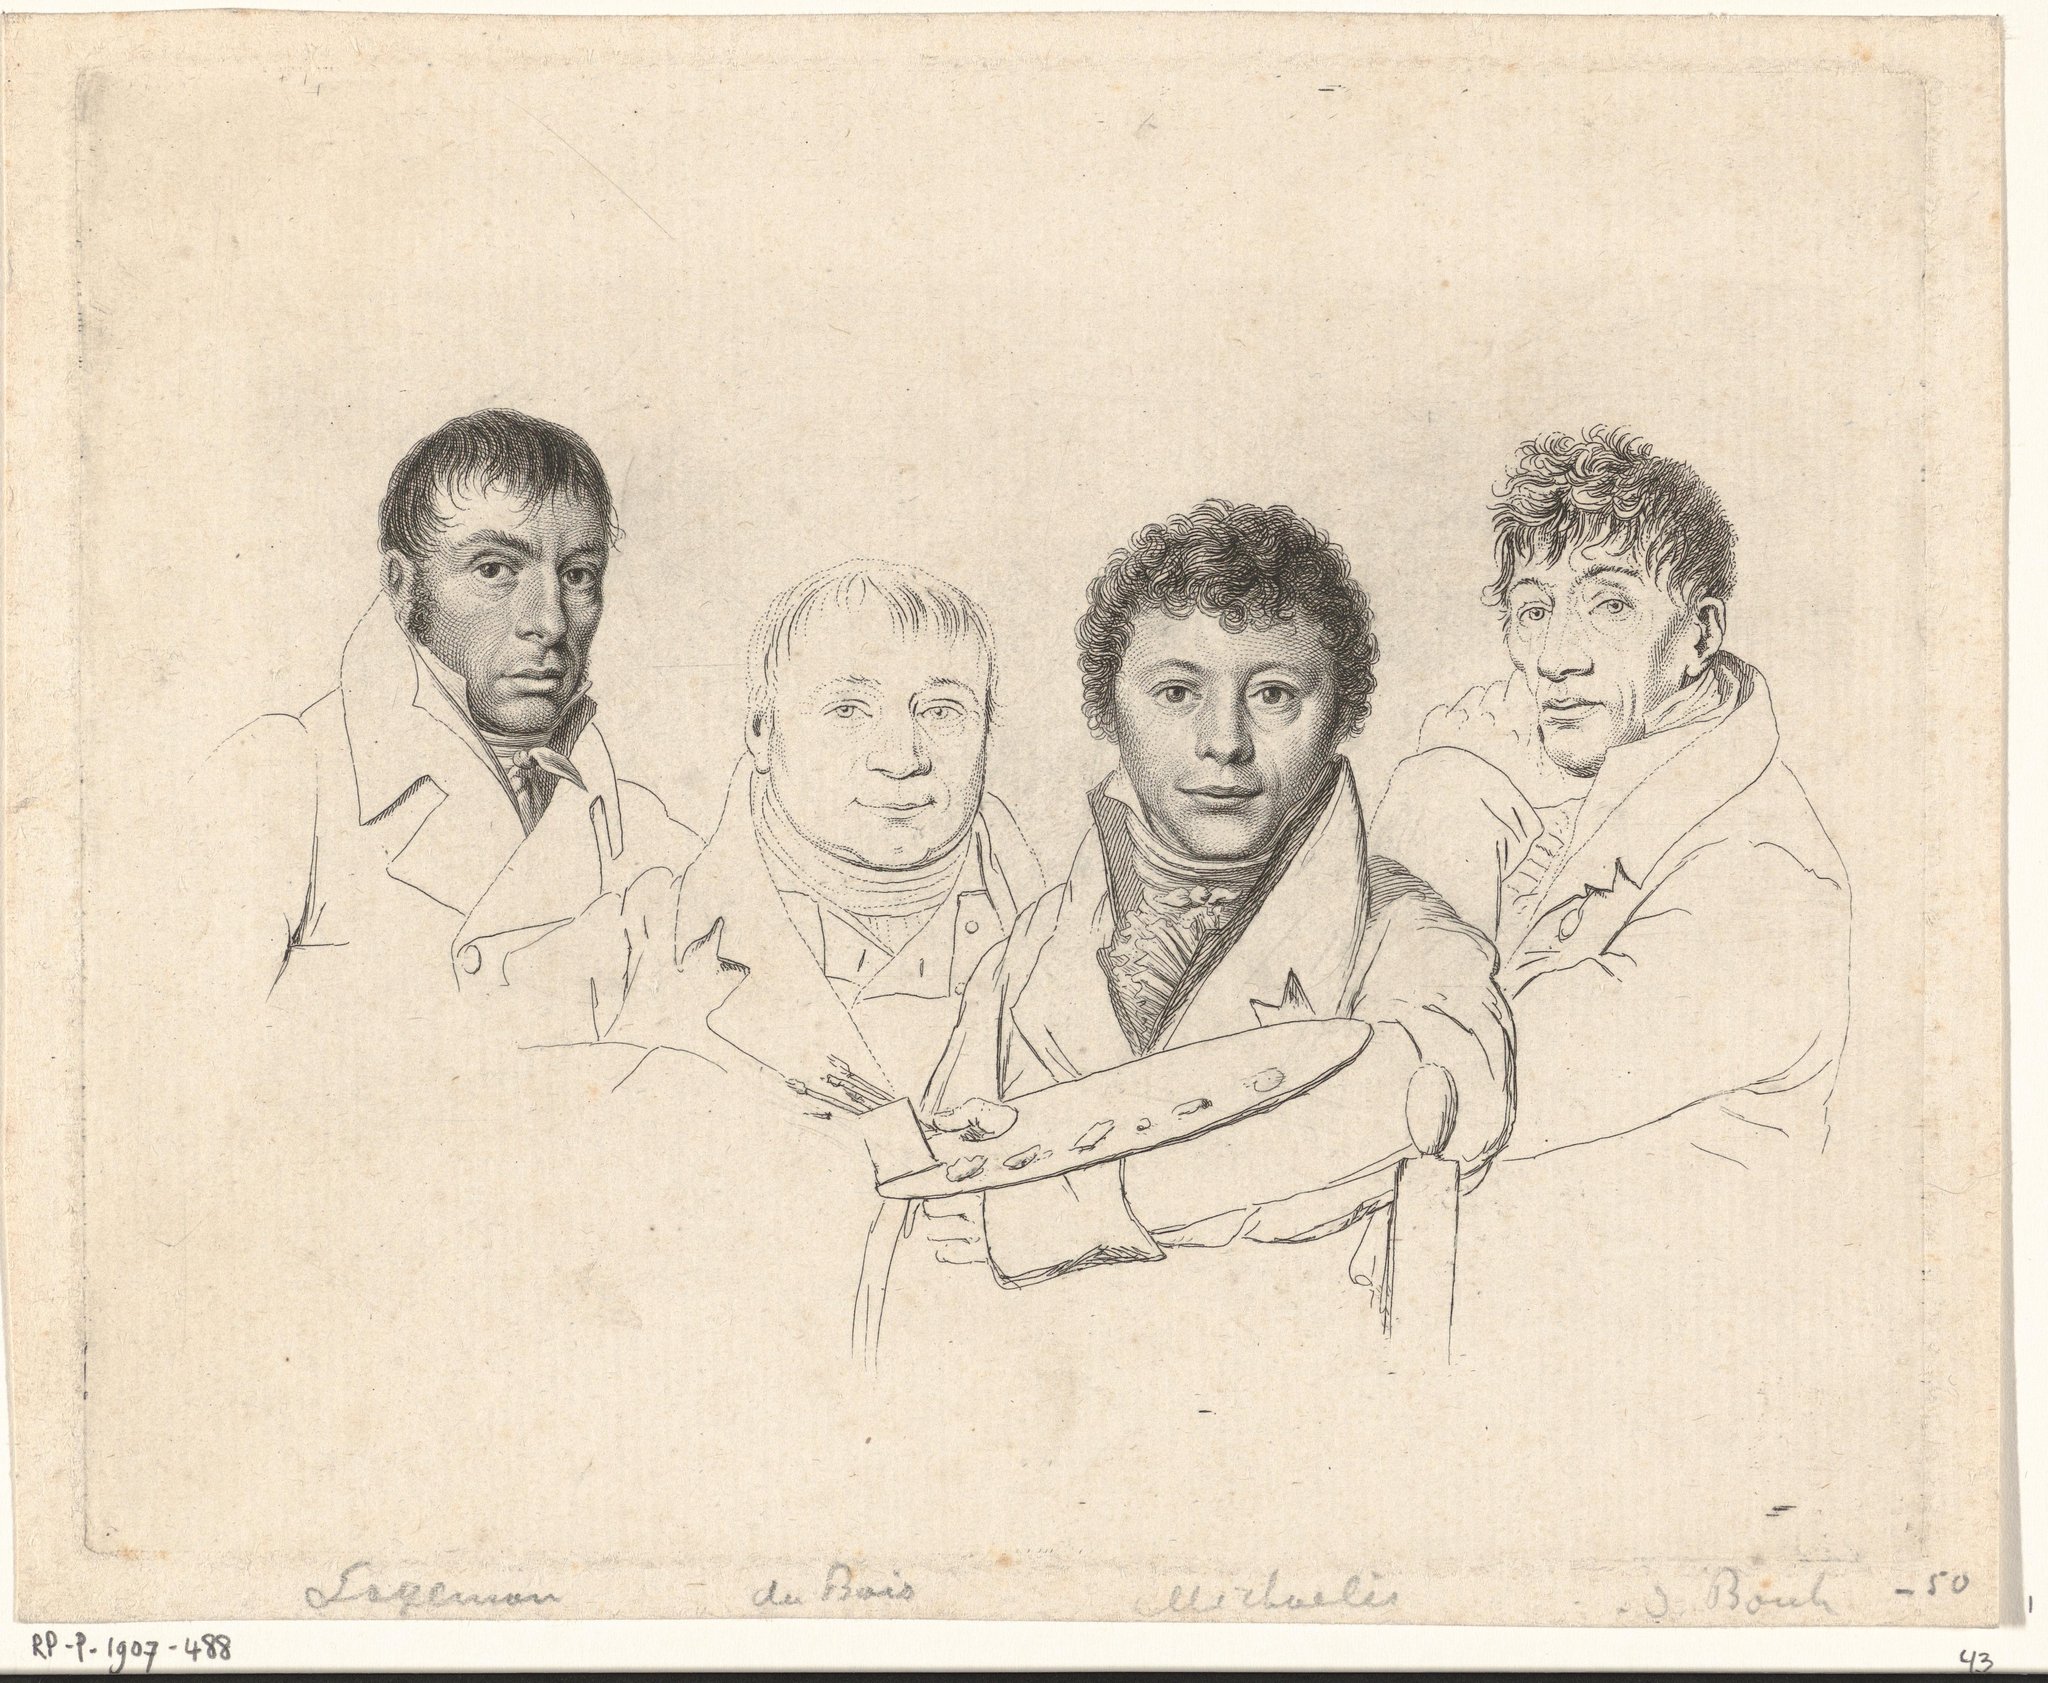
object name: print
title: Portretten van H. Lageman, Ch. Dubois, G.J. Michaëlis en A. van den Bos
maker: jacob ernst marcus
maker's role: draughtsman, print maker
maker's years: 1774-1826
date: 1811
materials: paper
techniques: etching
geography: amsterdam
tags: nijmegen, anthonie van den bos, amsterdam, print maker, draughtsman, chrétien dubois, haarlem, painter, gerrit jan michaëlis, hendrik lageman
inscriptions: name: ‘Lageman du Bois Michaelis v Bosch’, collector's mark: Lugt 2228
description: Portretten van de kunstenaars Hendrik Lageman, Chrétien Dubois, Gerrit Jan Michaëlis en Anthonie van den Bos.